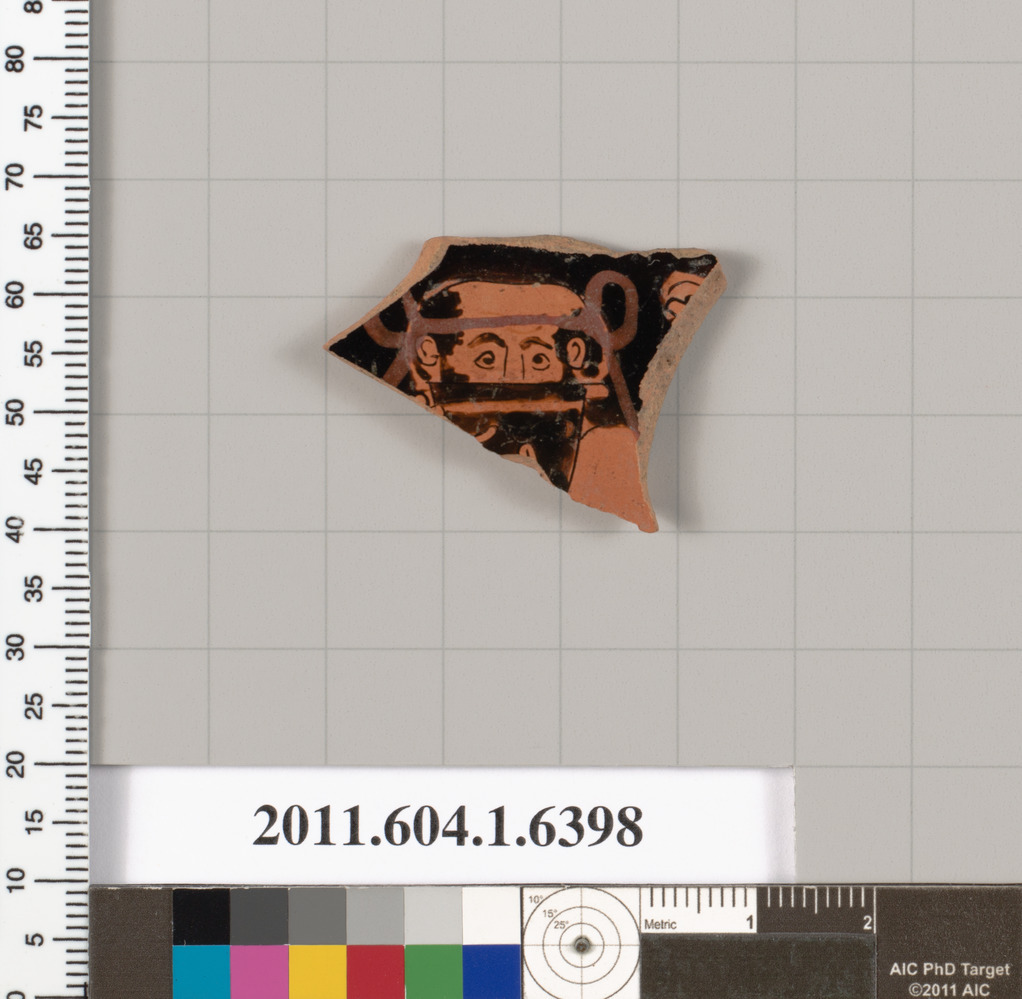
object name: kylix fragment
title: Terracotta fragment of a kylix (drinking cup)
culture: greek, attic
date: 490-480 BCE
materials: terracotta